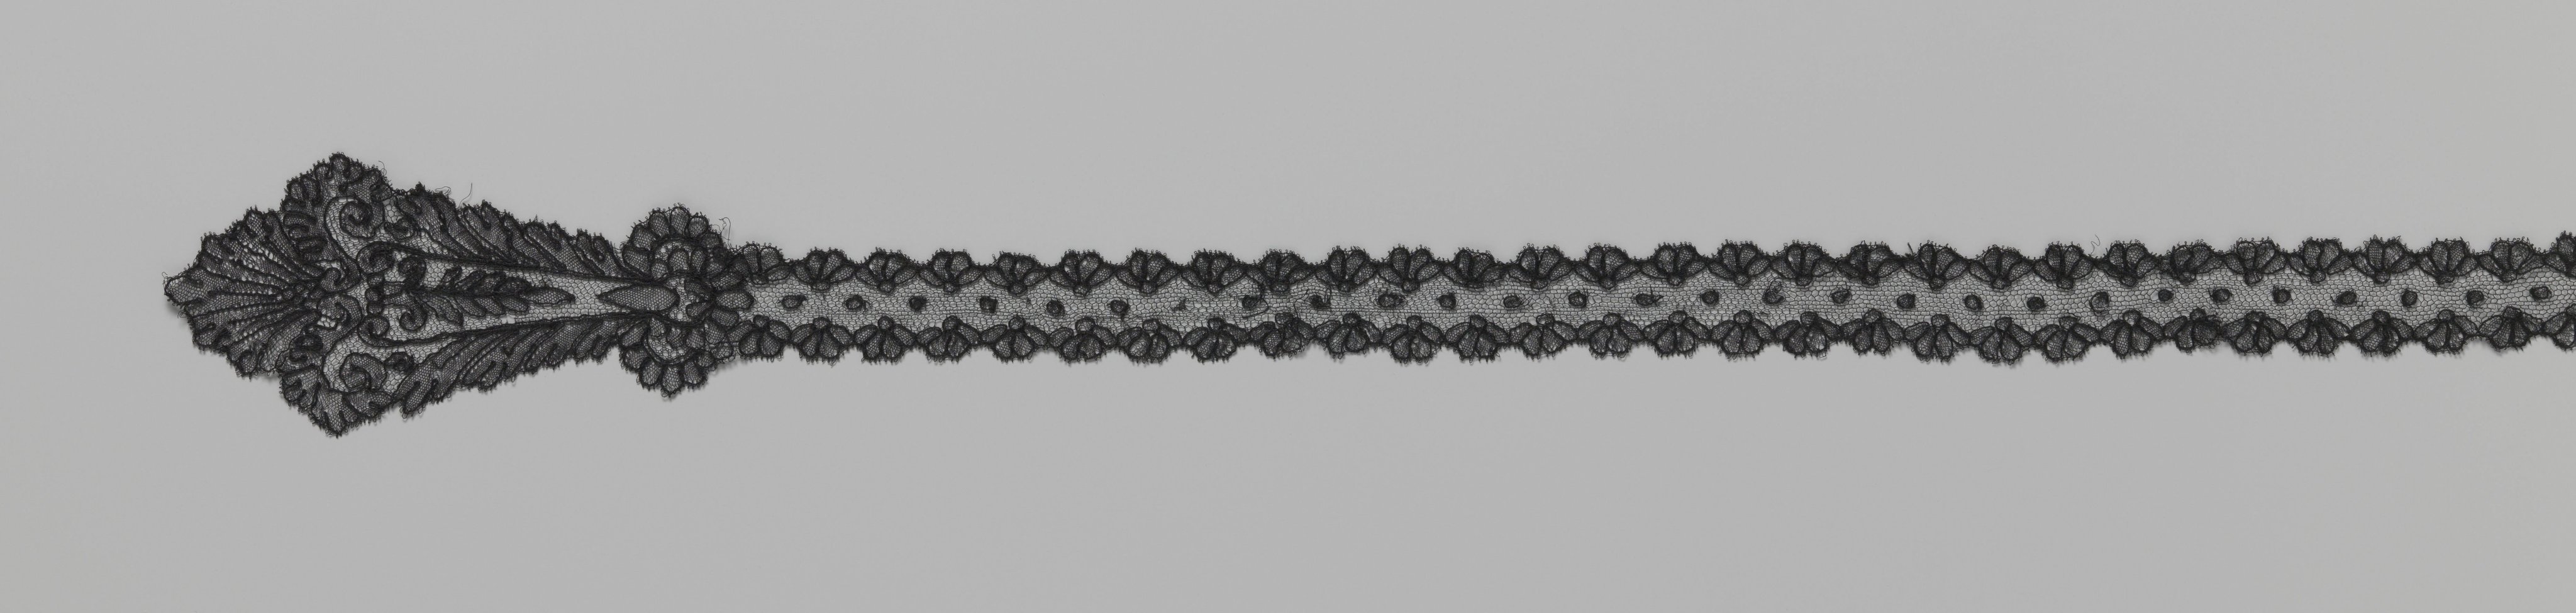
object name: neckcloth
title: Das of mutsenslip van kloskant in de vorm van klokkewijzers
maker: Anonymous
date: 1860-1880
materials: silk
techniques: lace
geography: belgium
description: Das of mutsenslip van zwarte kloskant: Chantilly-kant. Een langgerekt middenstuk met waaierbloempjes langs beide kanten wordt beëindigd met een nodus en breed uitlopende punten. De contouren van de laatste zijn gevormd van symmetrische akanthusbladeren met een bladpalmet in top.